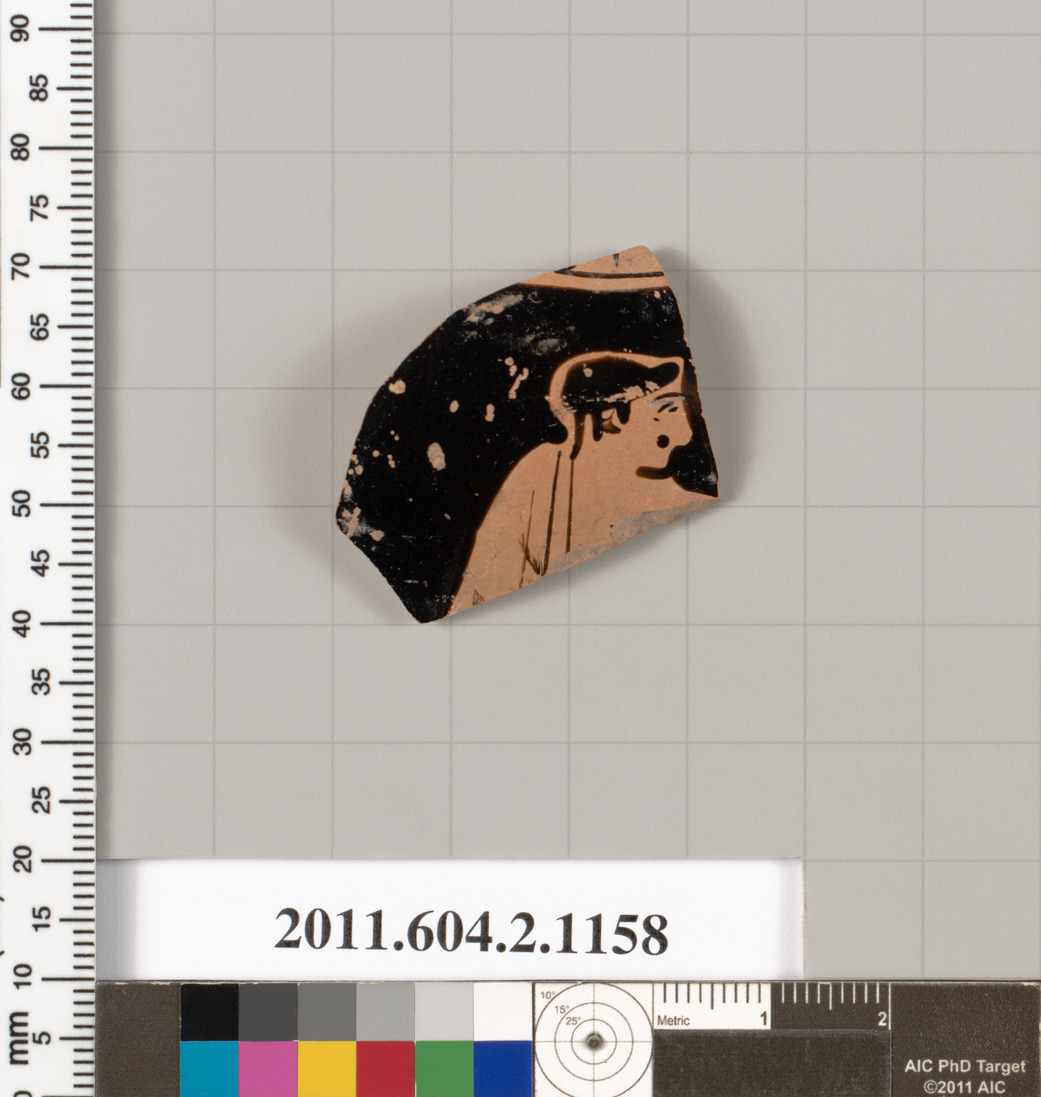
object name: chou fragment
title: Terracotta fragment of an oinochoe: chous (jug)?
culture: greek, attic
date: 450-426 BCE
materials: terracotta